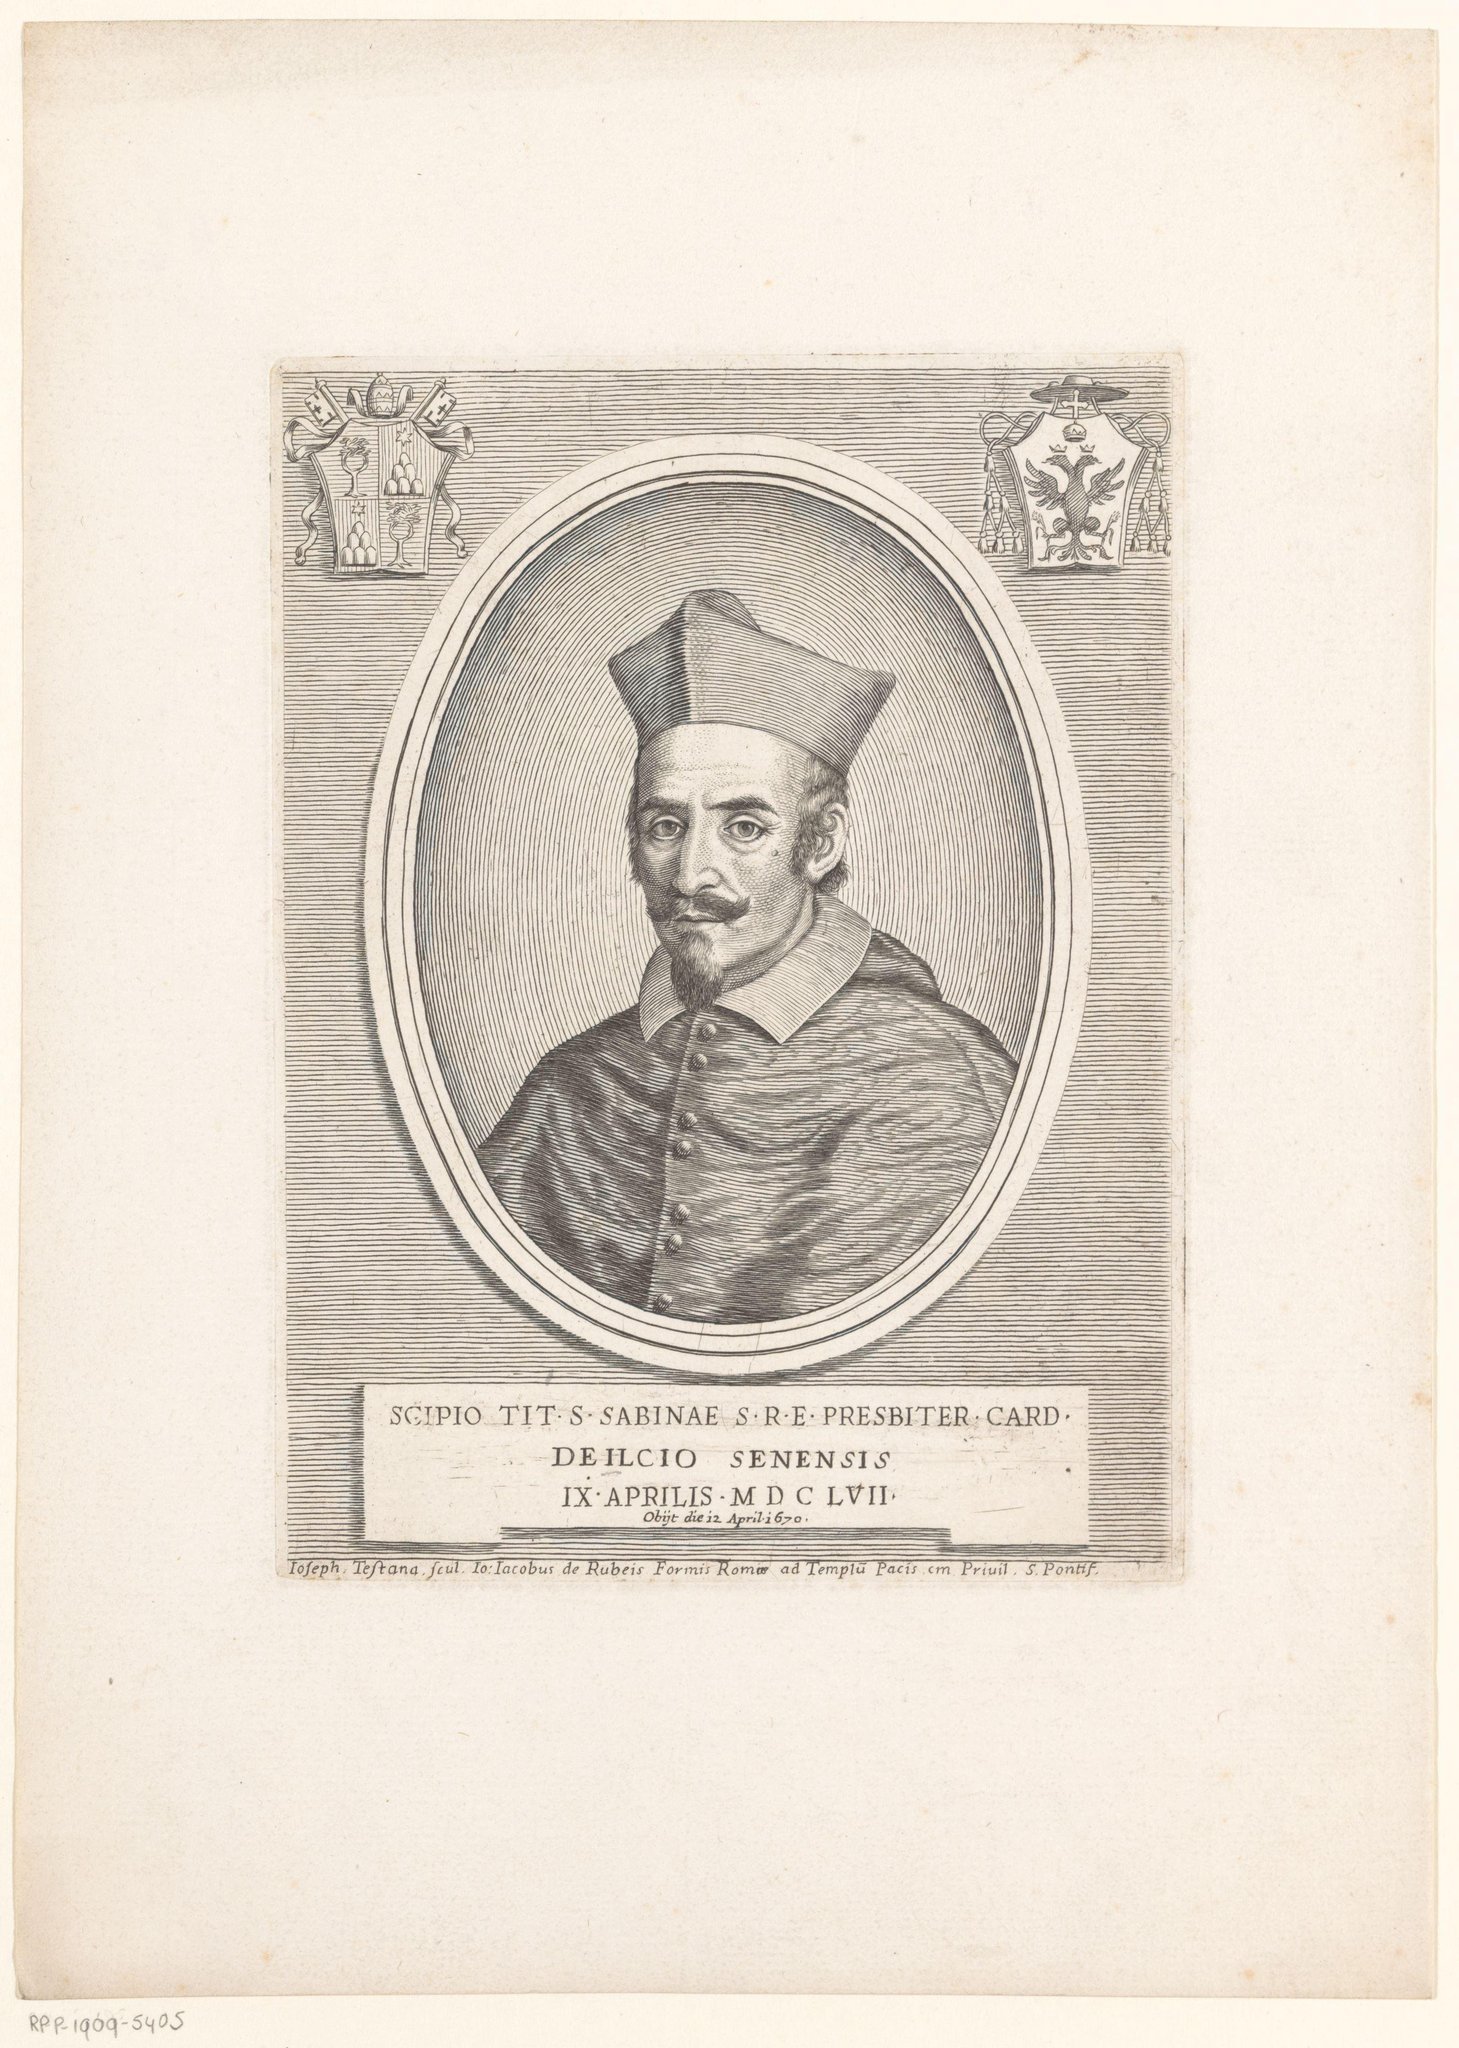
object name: print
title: Portretten van kardinalen met twee wapenschilden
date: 1658-1679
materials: paper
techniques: engraving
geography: italy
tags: rome, cardinal, historical persons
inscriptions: collector's mark: Lugt 2228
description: Prent uit een reeks van onbekende omvang met portretten van kardinalen. De prenten werden vanaf 1657 vervaardigd in opdracht van uitgever Giovanni Giacomo de’ Rossi, waarna de productie werd voortgezet onder leiding van zijn opvolgers Domenico de’ Rossi en Lorenzo Filippo de’ Rossi, en ten slotte onder leiding van de Calcographia R.C.A.